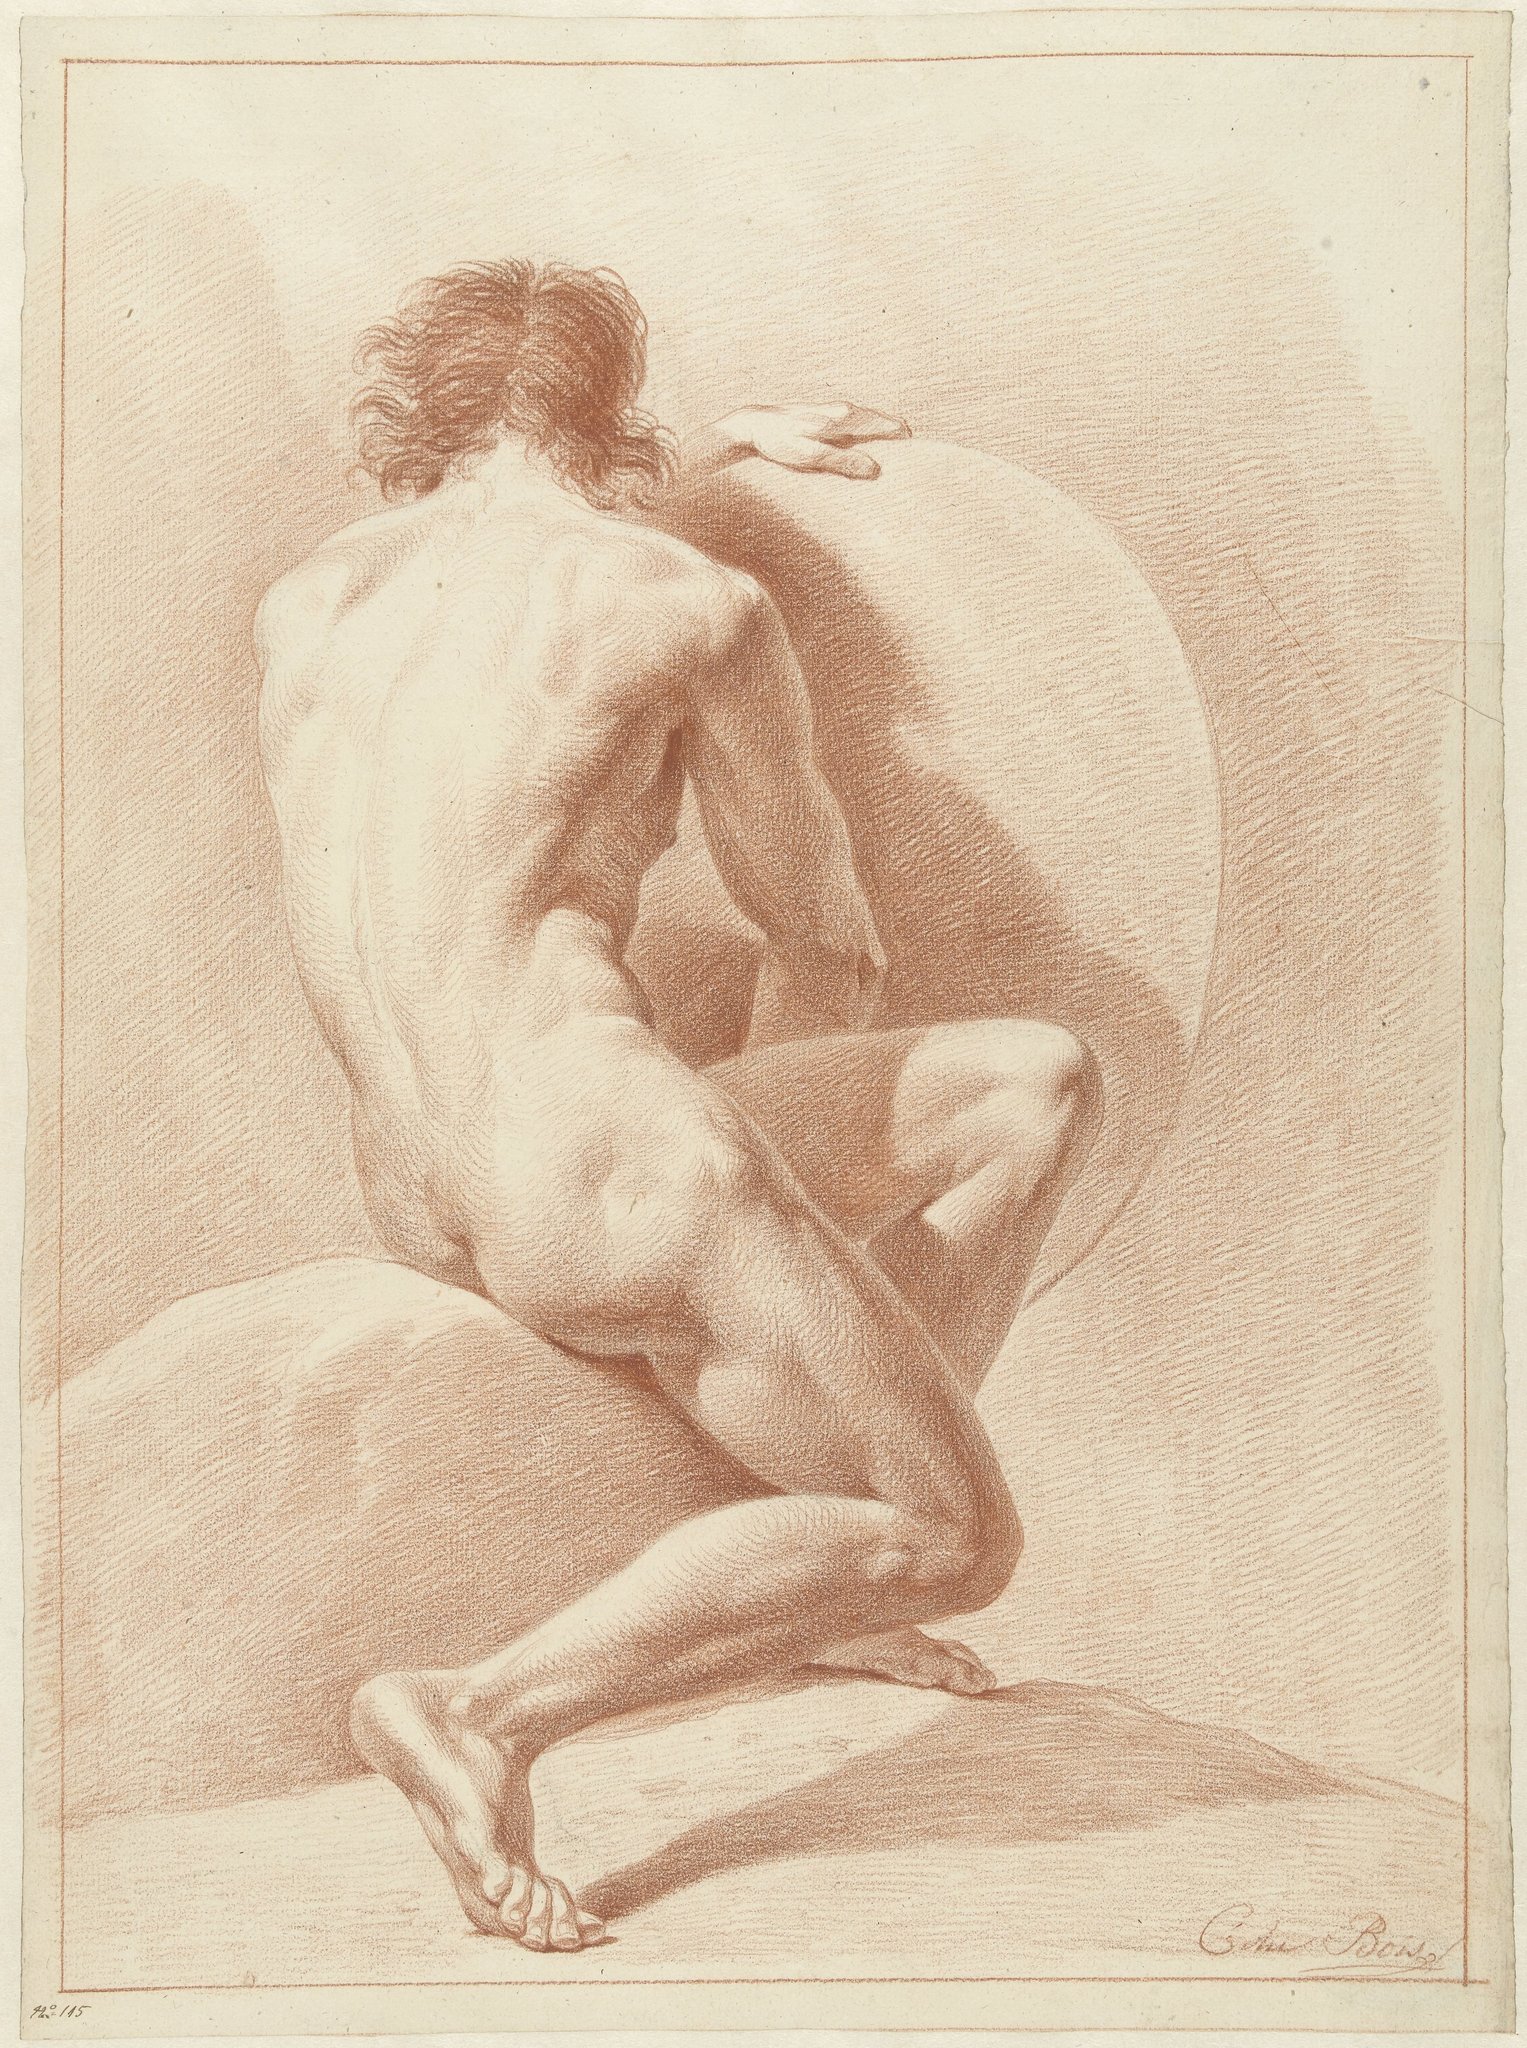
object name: drawing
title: Zittend mannelijk naakt, op de rug gezien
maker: chrétien dubois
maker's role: draughtsman, print maker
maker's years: 1765-1837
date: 1799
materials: chalk, paper